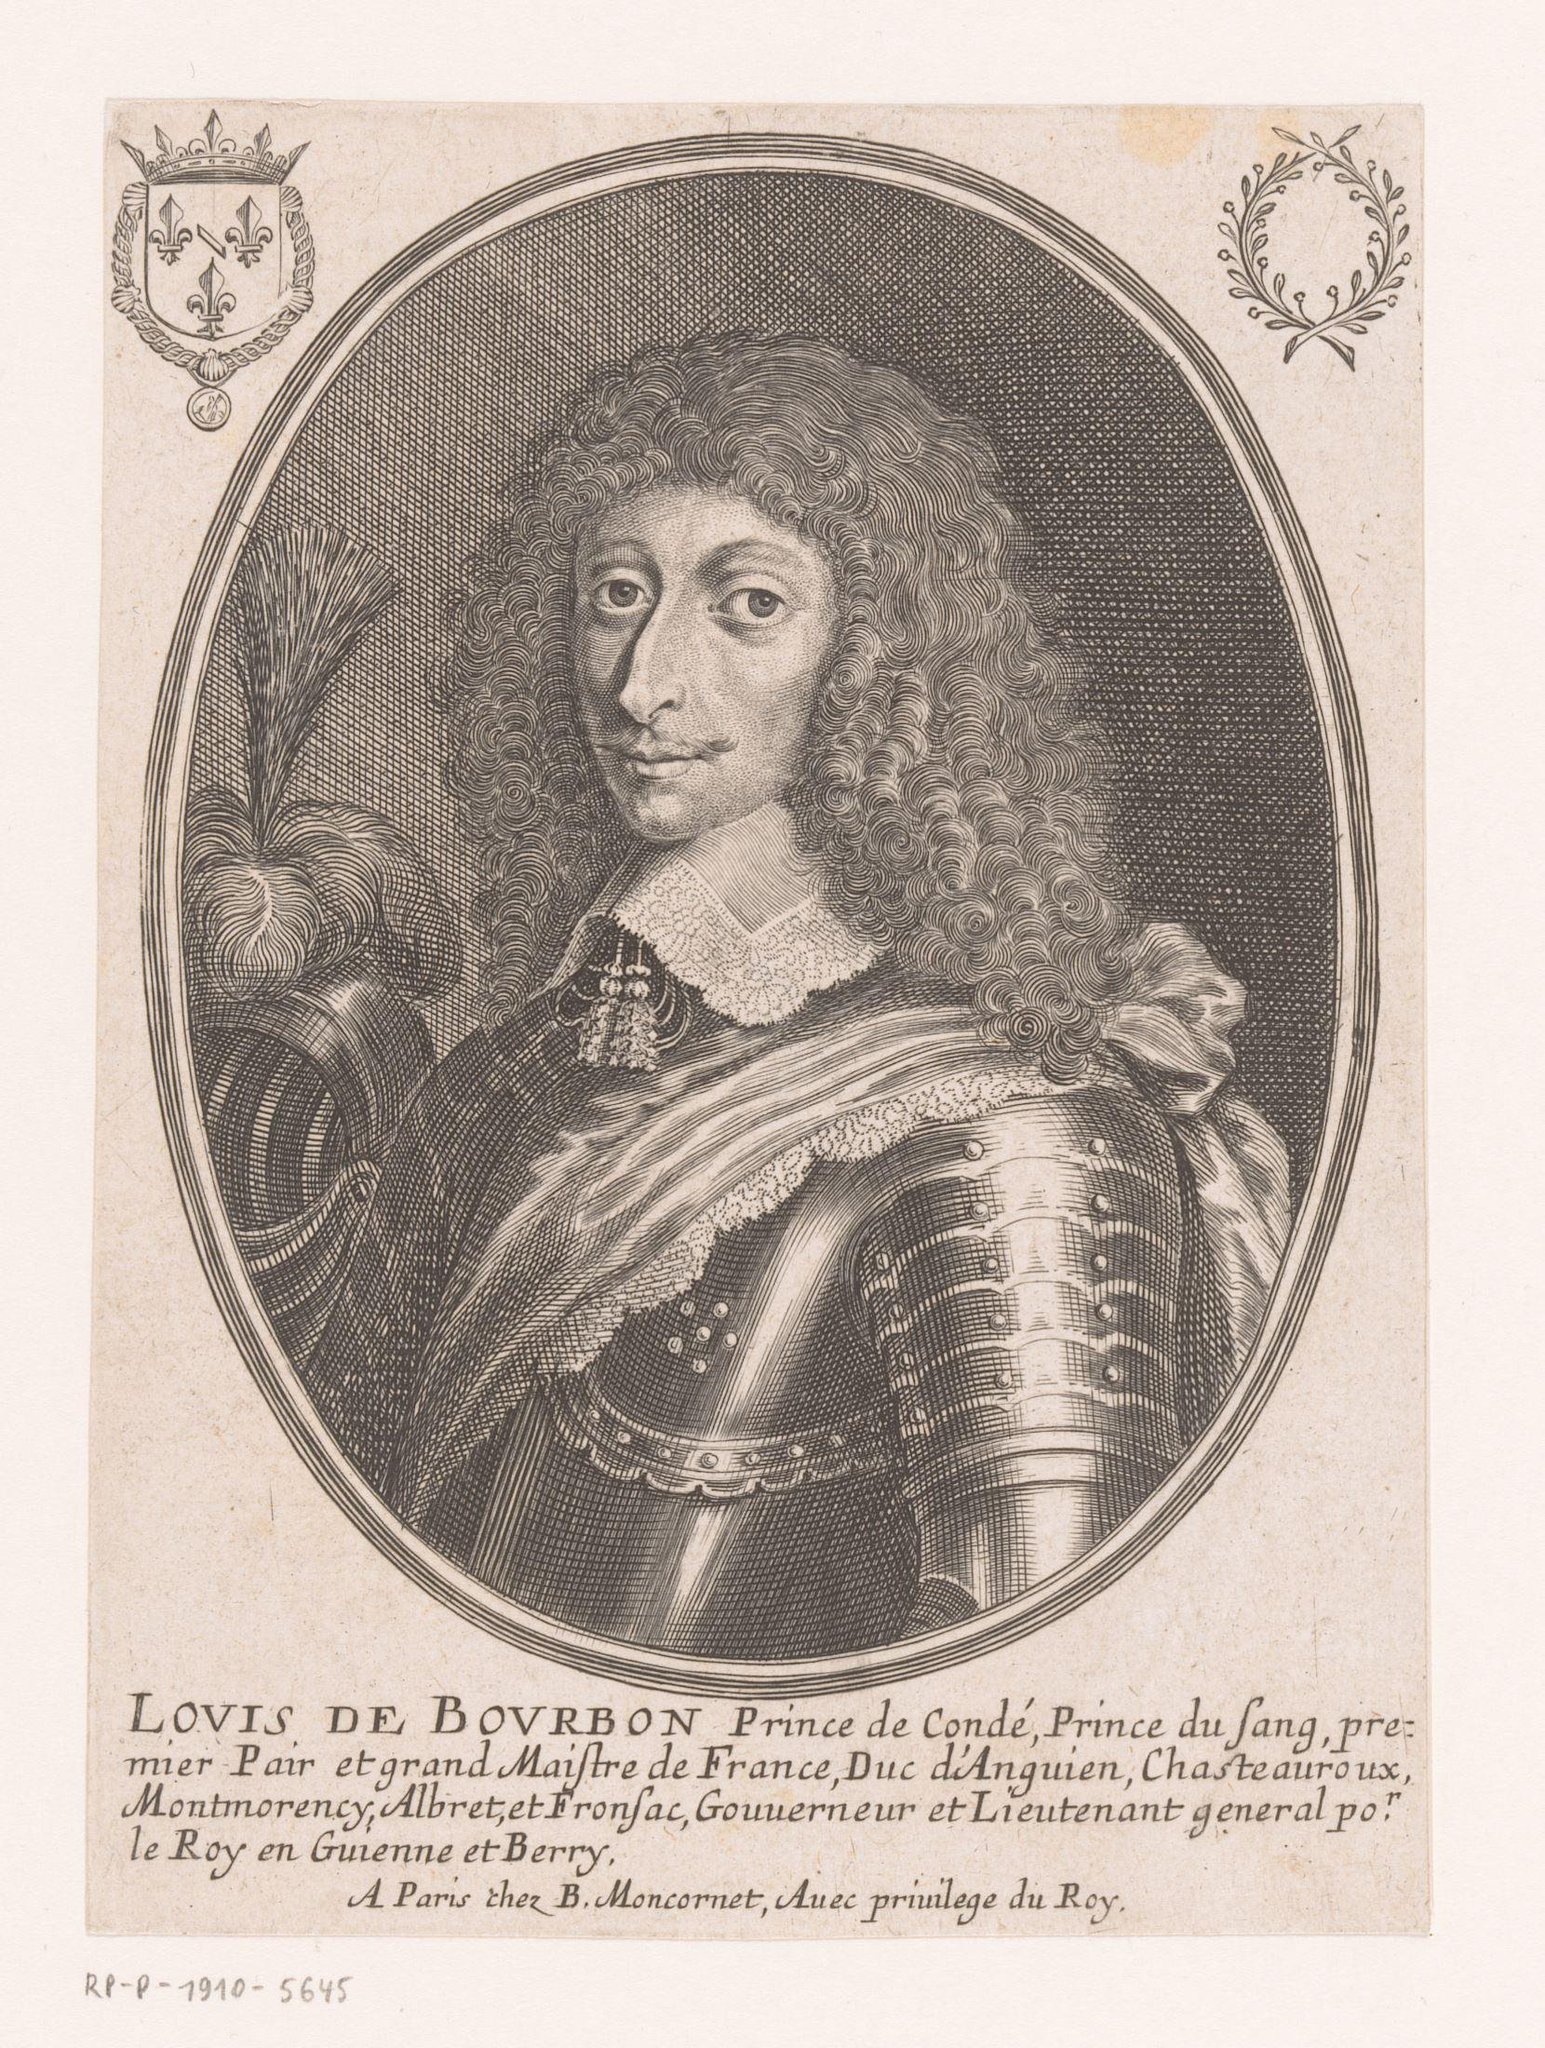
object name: print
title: Portret van Lodewijk II van Bourbon-Condé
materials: paper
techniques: engraving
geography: france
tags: lodewijk ii de bourbon-condé (hertog van enghien), ranks in the army, historical persons, nobility and patriciate; chivalry, knighthood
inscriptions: collector's mark: Lugt 2228